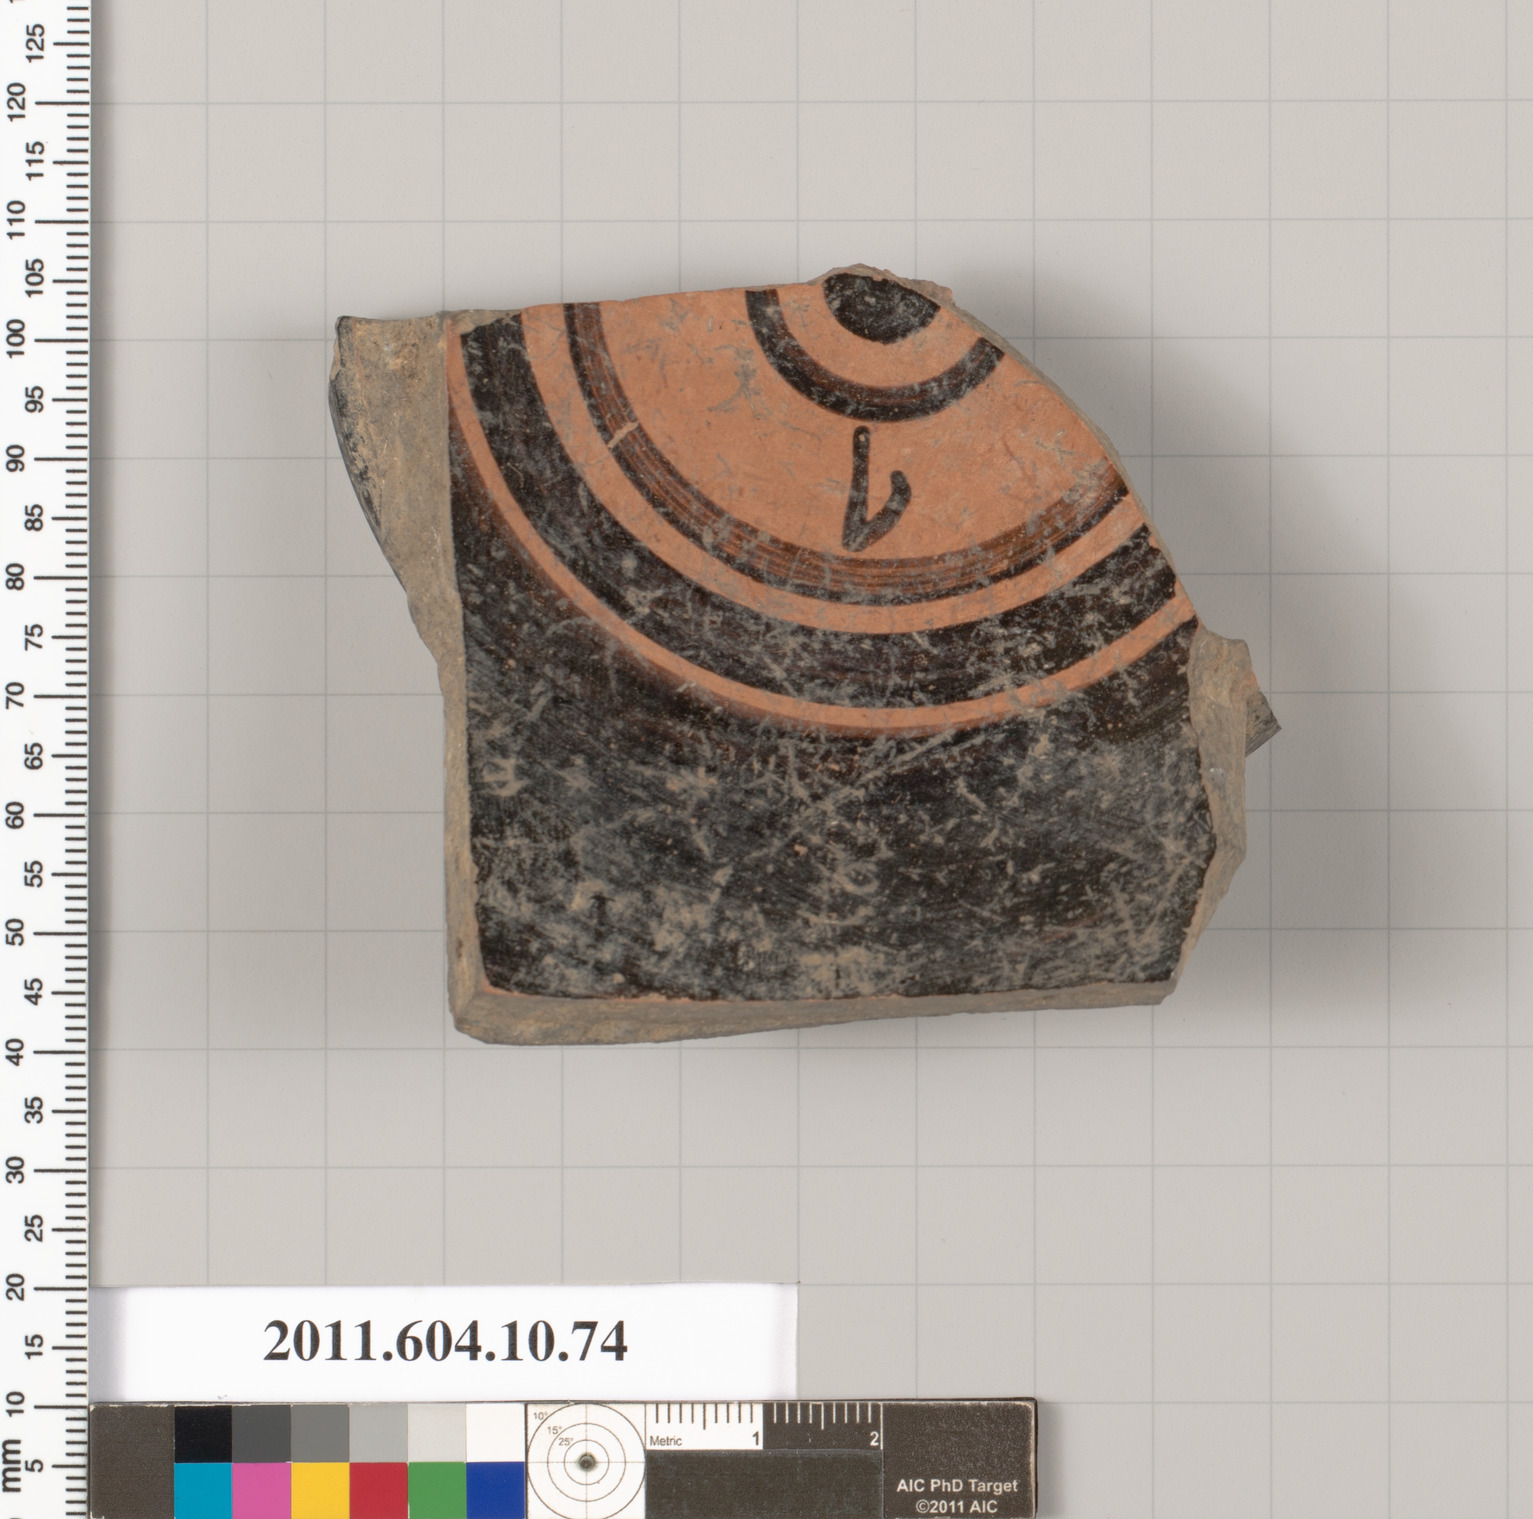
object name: fragment of a bowl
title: Terracotta fragment of a bowl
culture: etruscan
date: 400-301 BCE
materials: terracotta